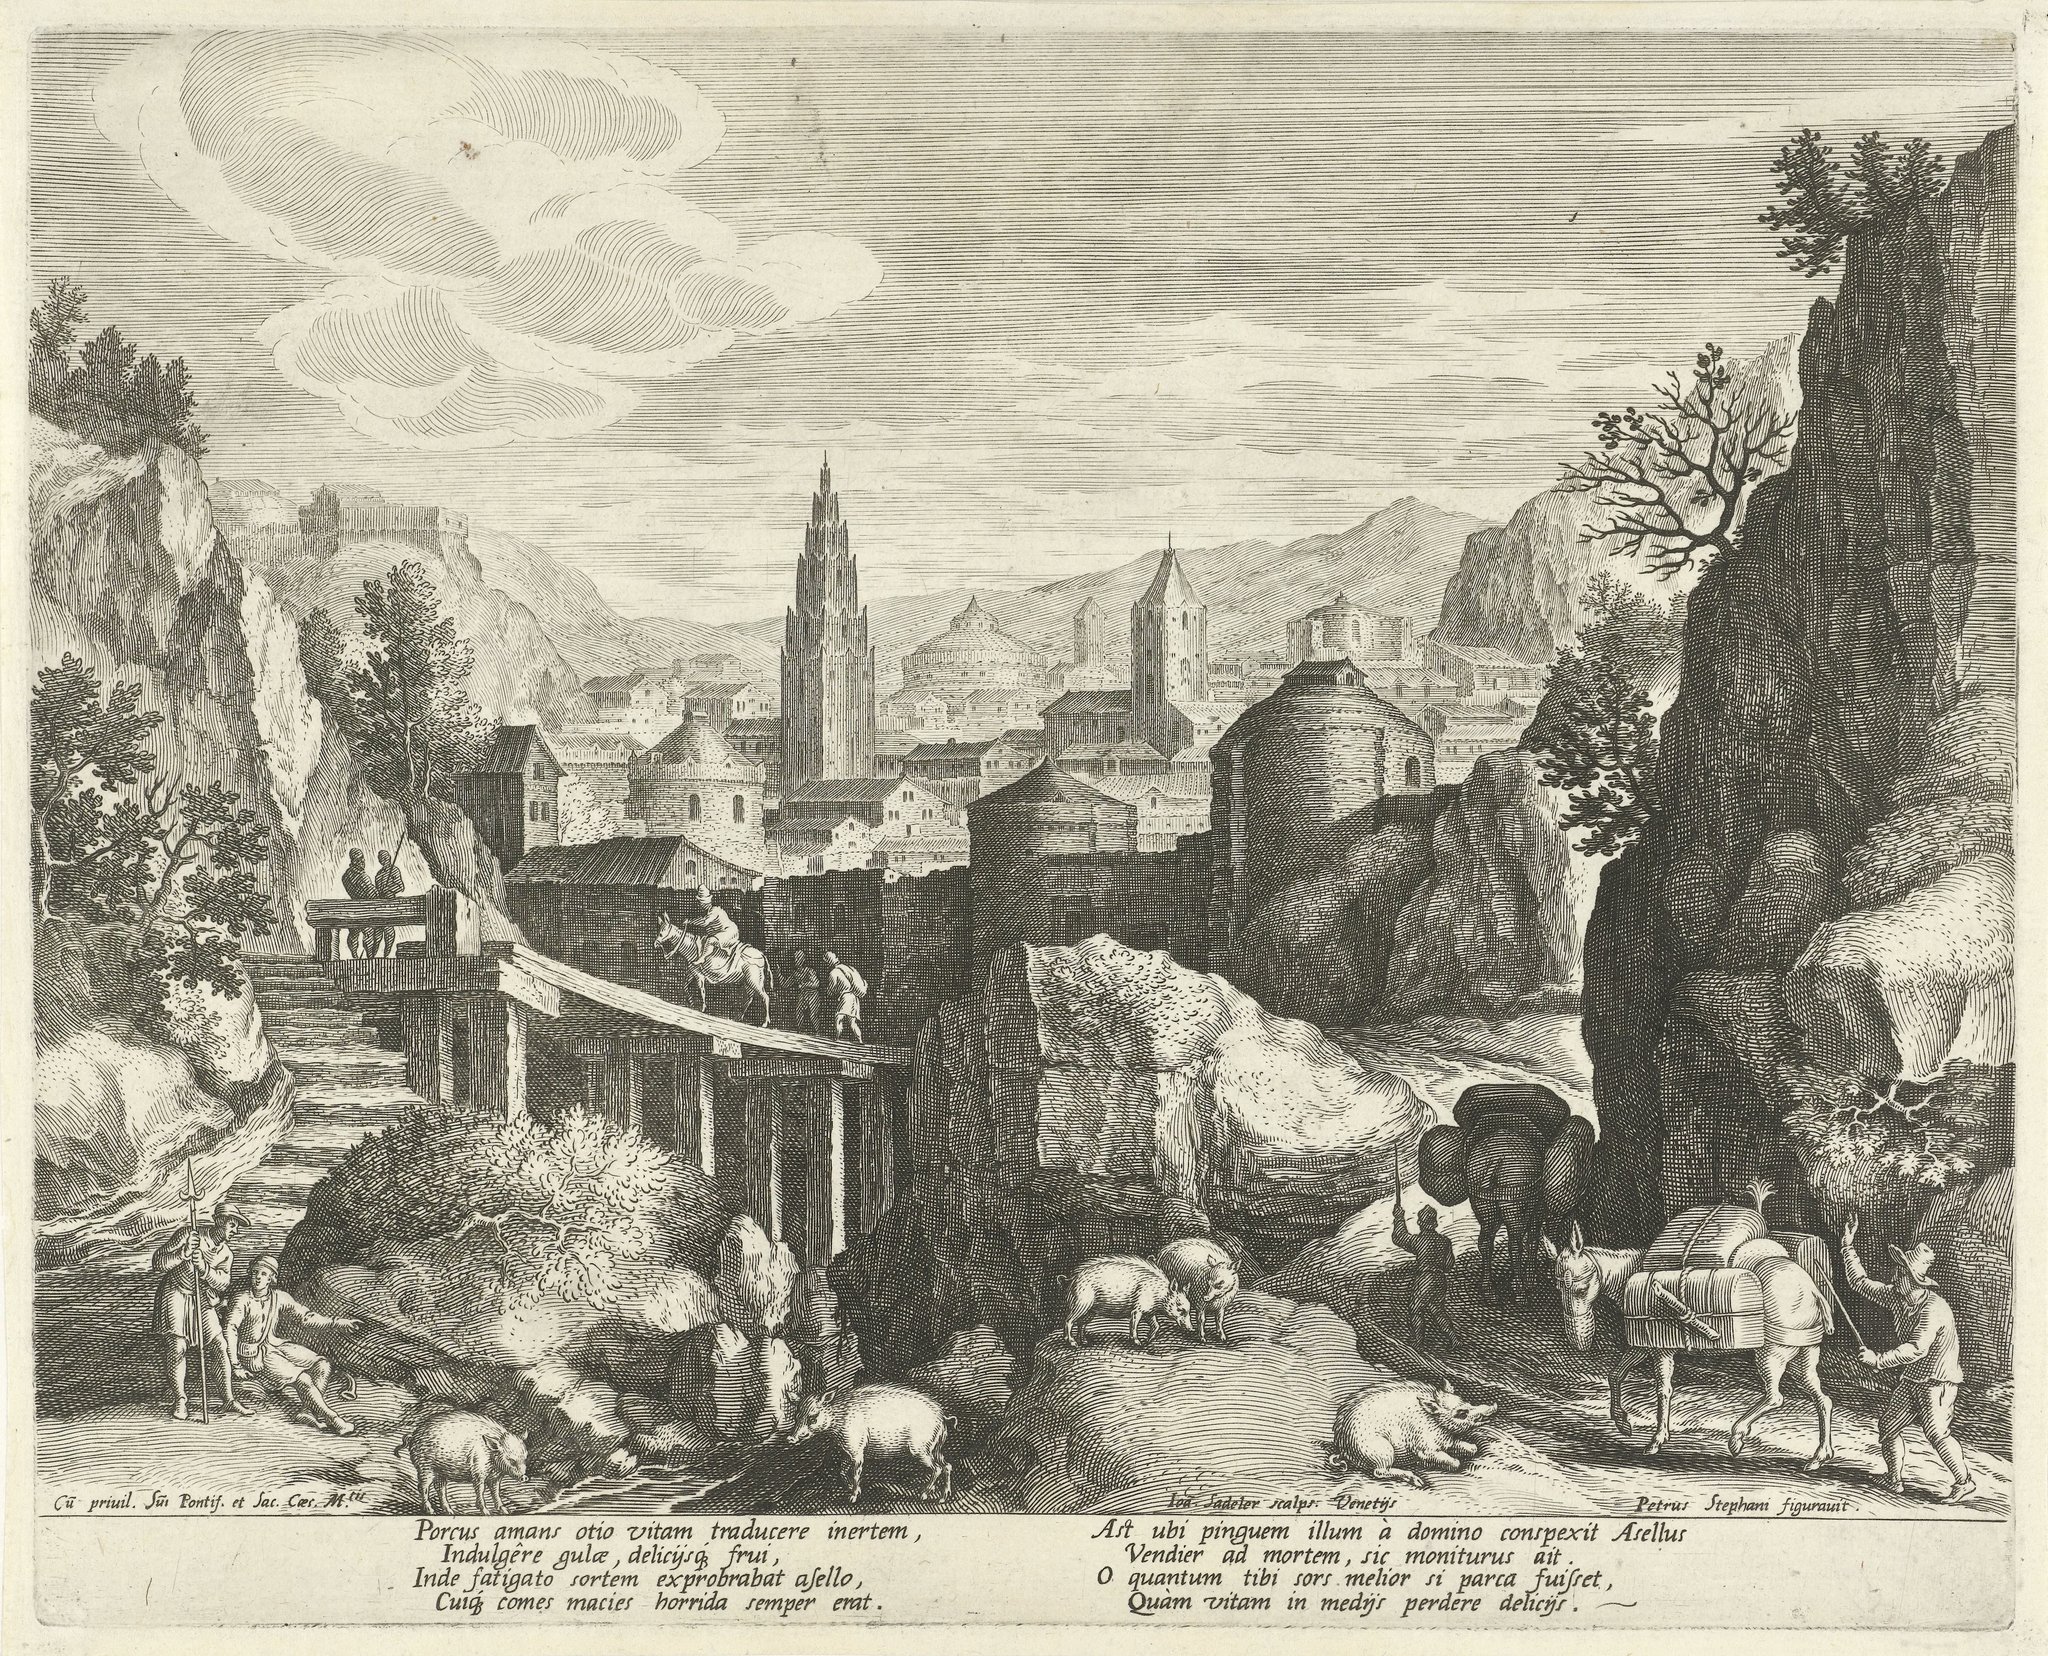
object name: print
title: Rotsachtig landschap met de fabel van de ezel en het wilde zwijn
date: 1595-1600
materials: paper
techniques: engraving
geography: venice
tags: idleness; 'otio' (ripa), pig, ass, donkey, fables, rocks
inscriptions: collector's mark: Lugt 240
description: Rotsachtig landschap met een stad op de achtergrond. Links een trap in de heuvels en een houten brug. Op de voorgrond vijf zwijnen. Rechts komen twee beladen ezels de berg op. Een van de ezels confronteert een zwijn met zijn luiheid. Dit is de verbeelding van een fabel van de ezel en het wilde zwijn. De prent heeft een Latijns onderschrift over de fabel.